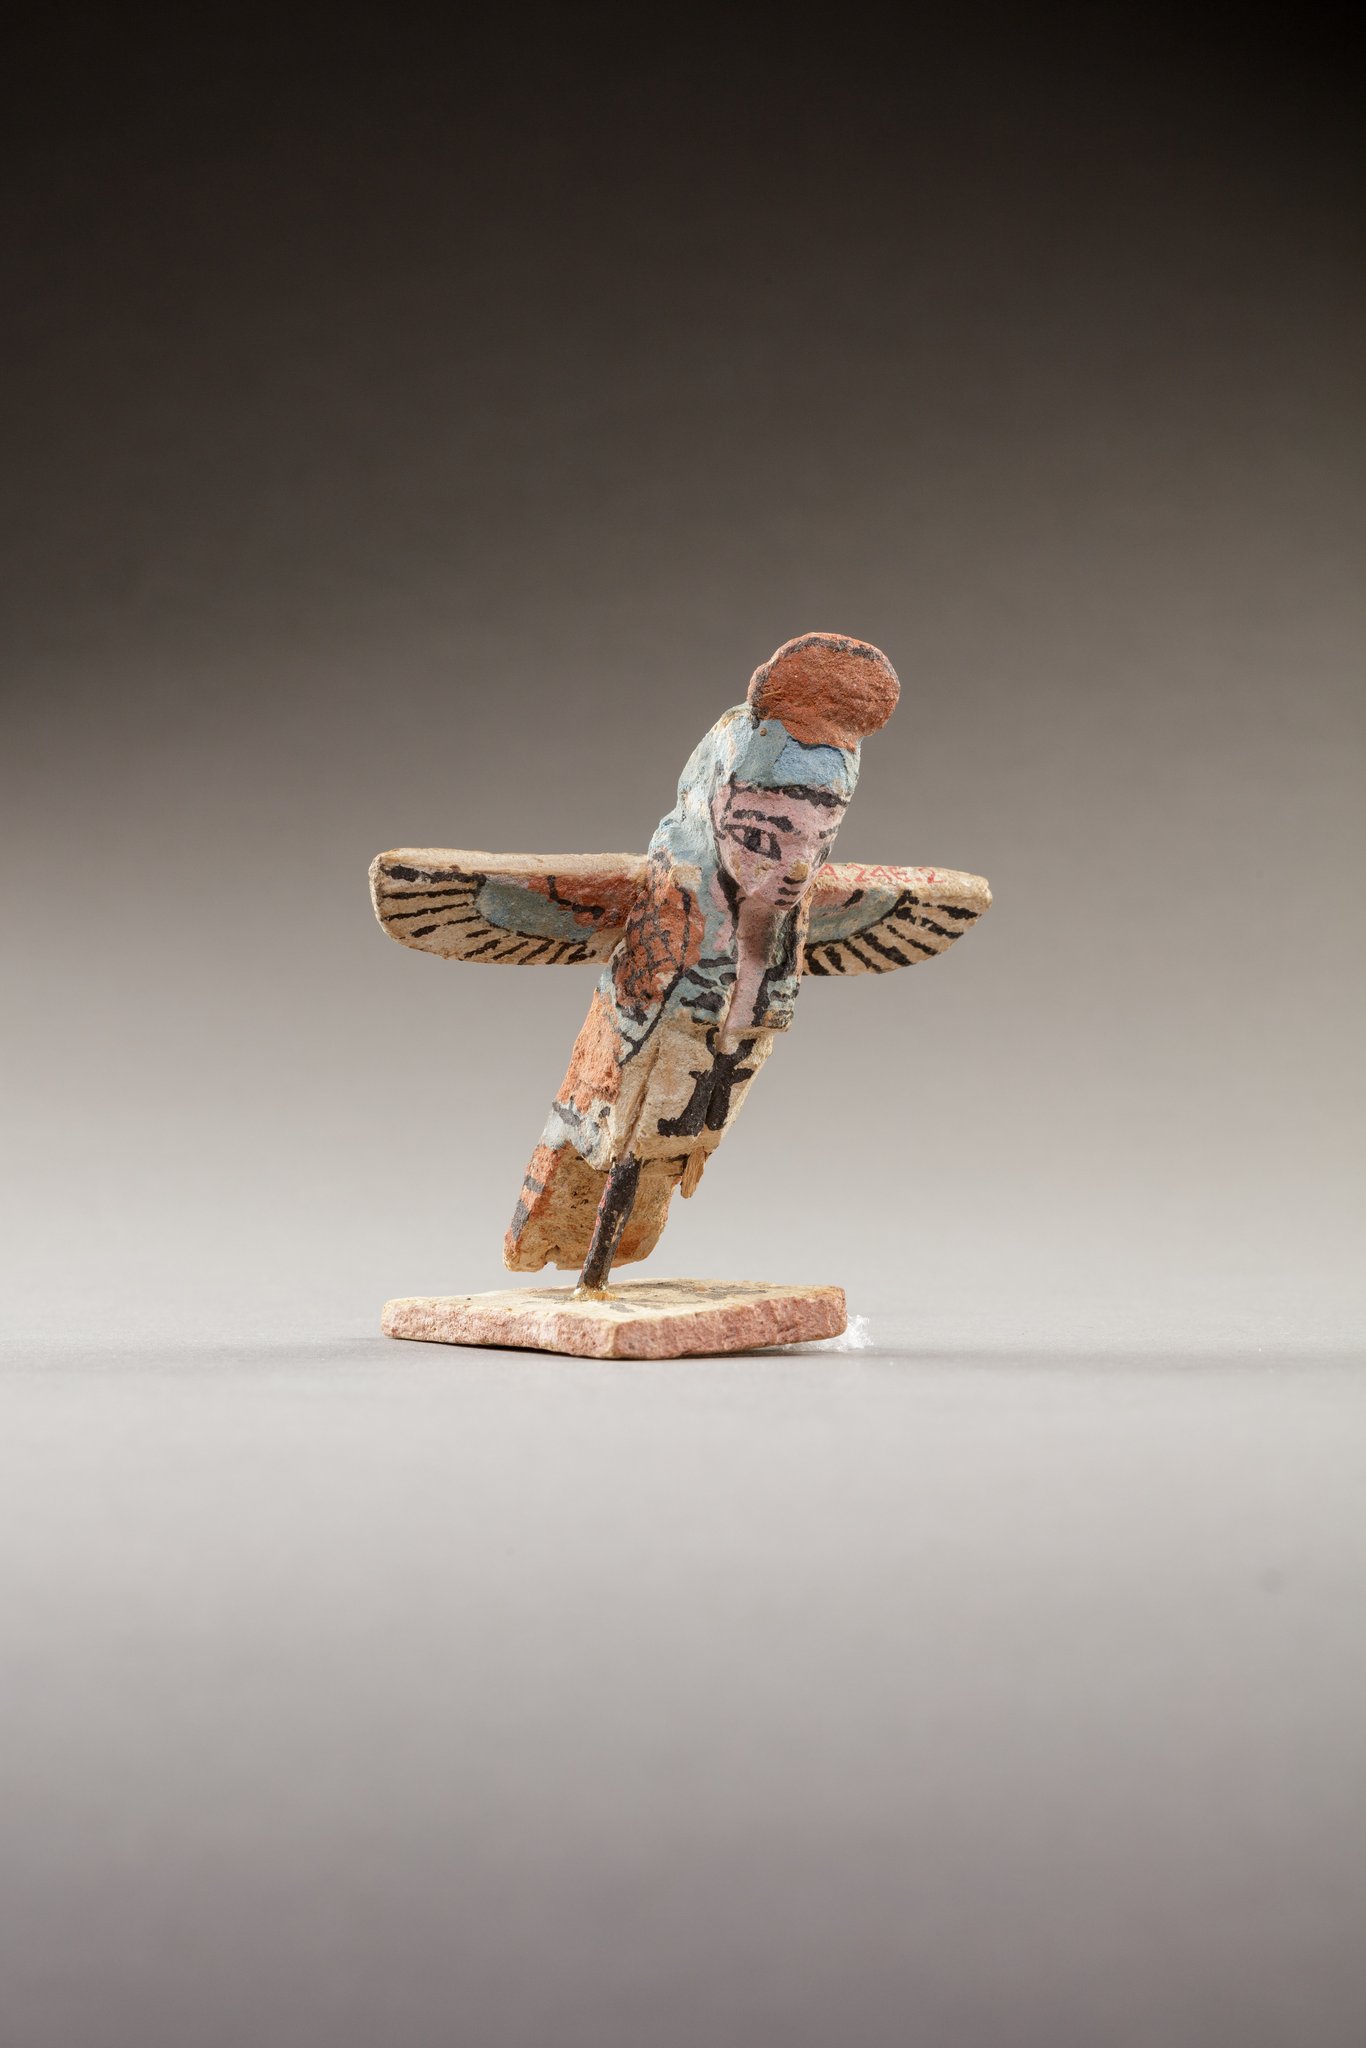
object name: ba bird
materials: paint, wood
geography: egypt